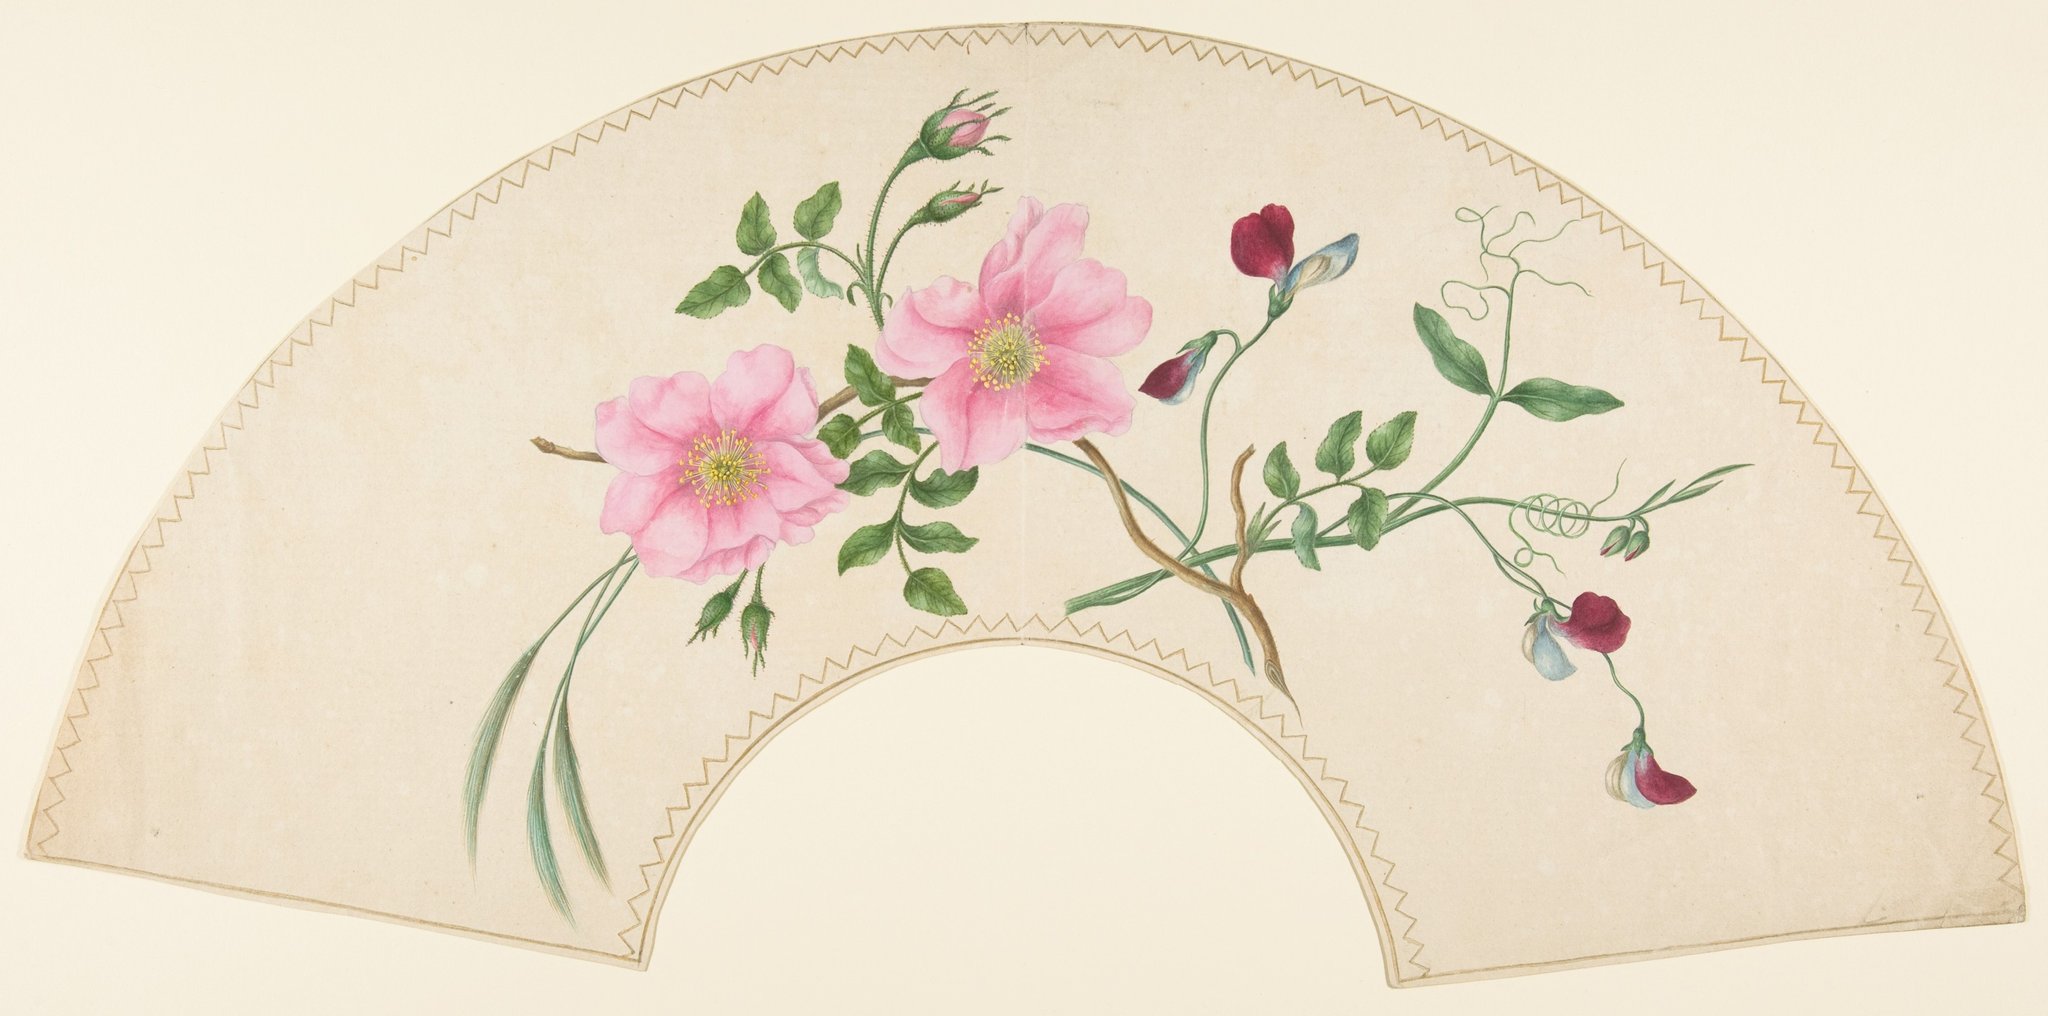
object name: drawing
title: Fan Design with Flower Motifs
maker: anonymous, french, 19th century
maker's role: artist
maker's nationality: french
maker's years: 1800-1900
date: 1801-1900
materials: graphite, watercolor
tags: fans,flowers